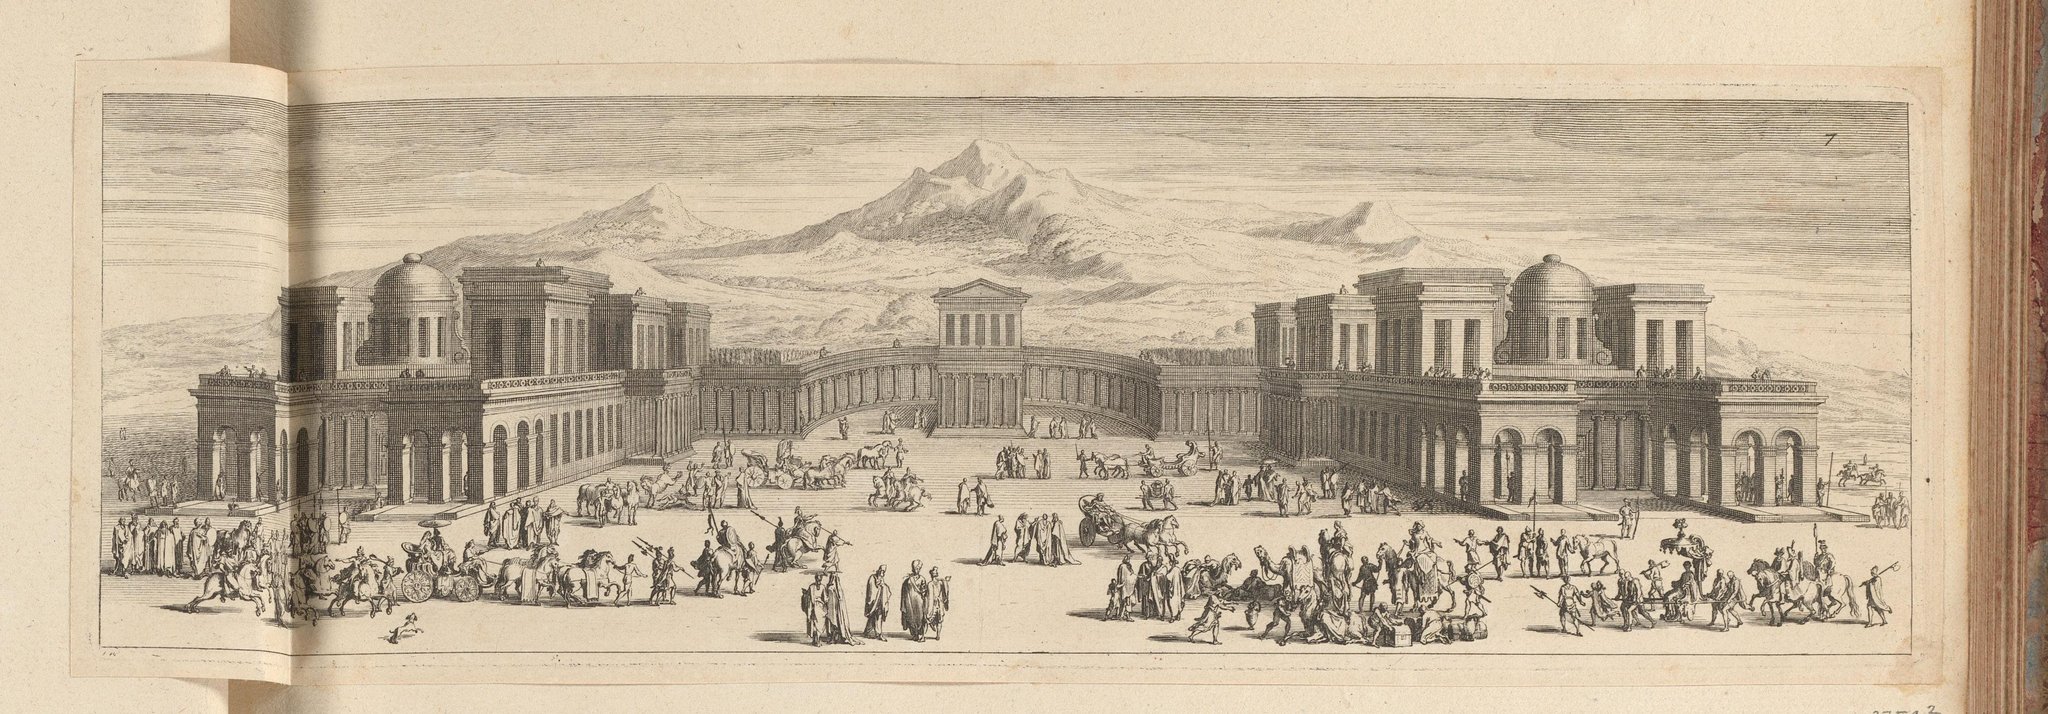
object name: print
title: Gezicht op een paleis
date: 1695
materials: paper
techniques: etching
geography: paris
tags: the palace of solomon (1 kings 7:1-12), palace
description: Prent uit: Maillet, Abbé Louis. Les Figures du temple et du palais de Salomon (...). Parijs: Guillaume Desprez, 1695.